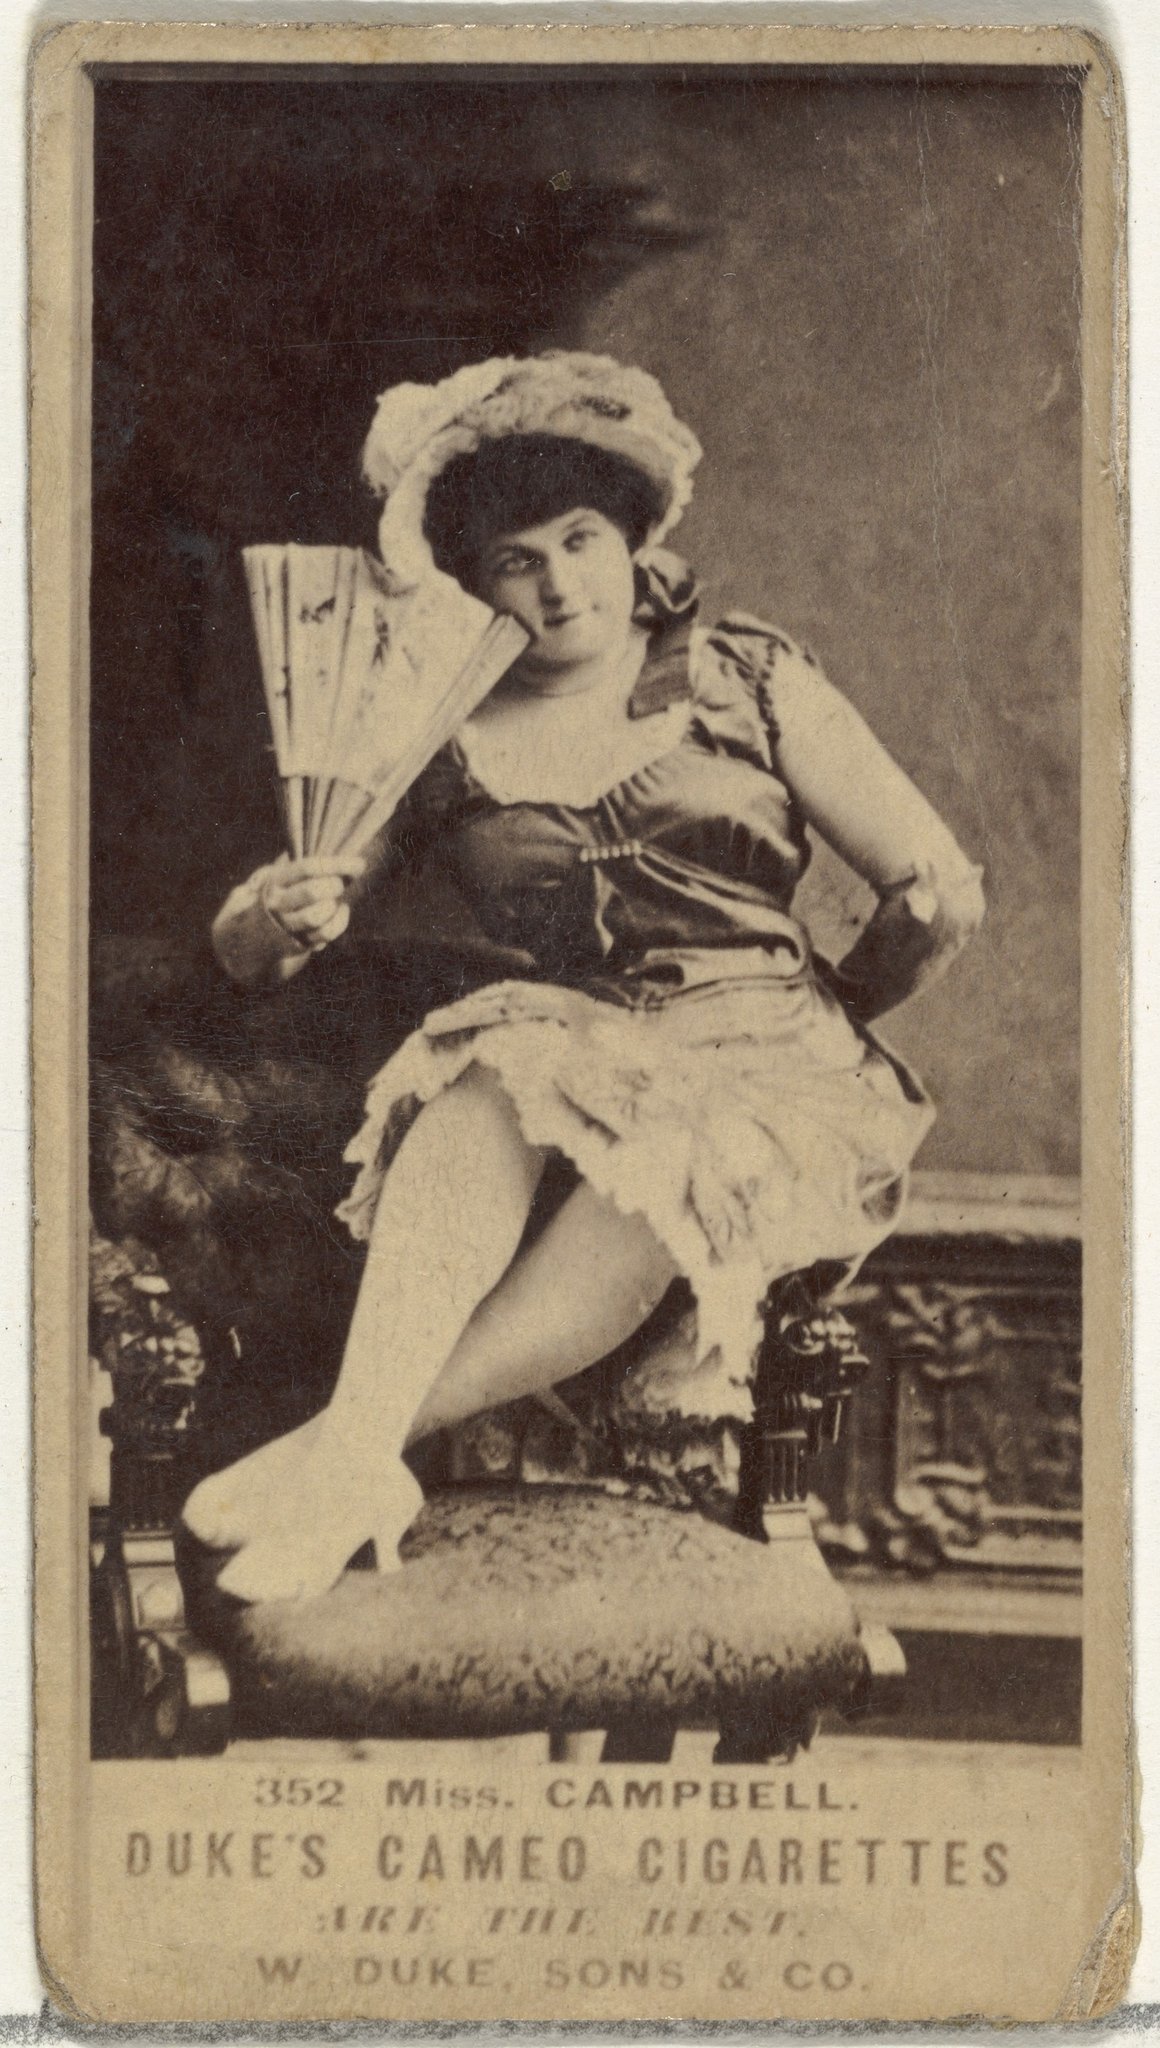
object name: photograph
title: Card Number 352, Miss Campbell, from the Actors and Actresses series (N145-5) issued by Duke Sons & Co. to promote Cameo Cigarettes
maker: w. duke, sons & co.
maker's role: publisher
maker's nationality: american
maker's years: 1870-1920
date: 1880-1889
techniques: albumen silver print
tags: portraits,women,actresses